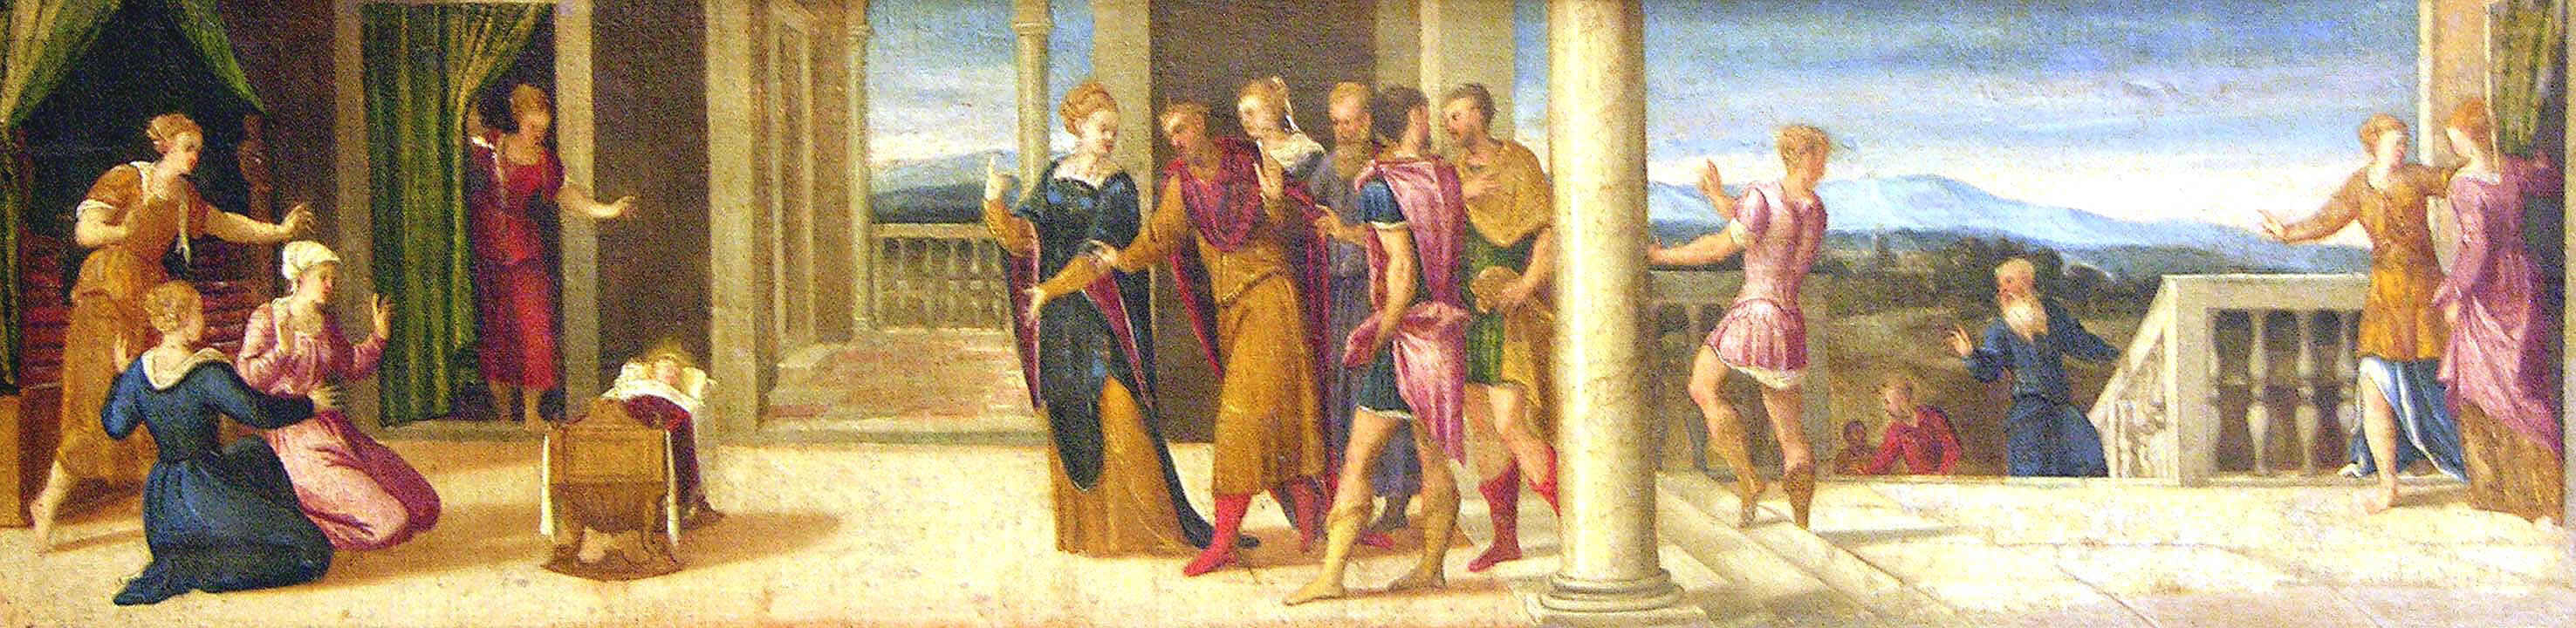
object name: painting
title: The Legend of the Infant Servius Tullius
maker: bonifacio de' pitati (bonifacio veronese)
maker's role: artist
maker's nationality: italian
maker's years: 1487-1553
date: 1507-1553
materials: canvas, oil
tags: infants,men,women,cradles